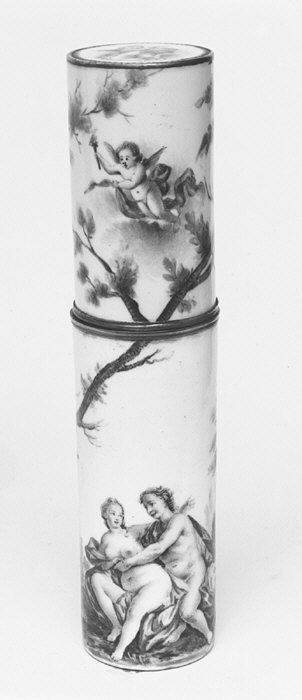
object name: needle case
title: Needle case (Étui)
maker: vincennes manufactory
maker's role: manufactory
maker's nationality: french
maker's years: 1740-1756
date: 1752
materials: gold, soft paste porcelain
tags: female nudes,angels